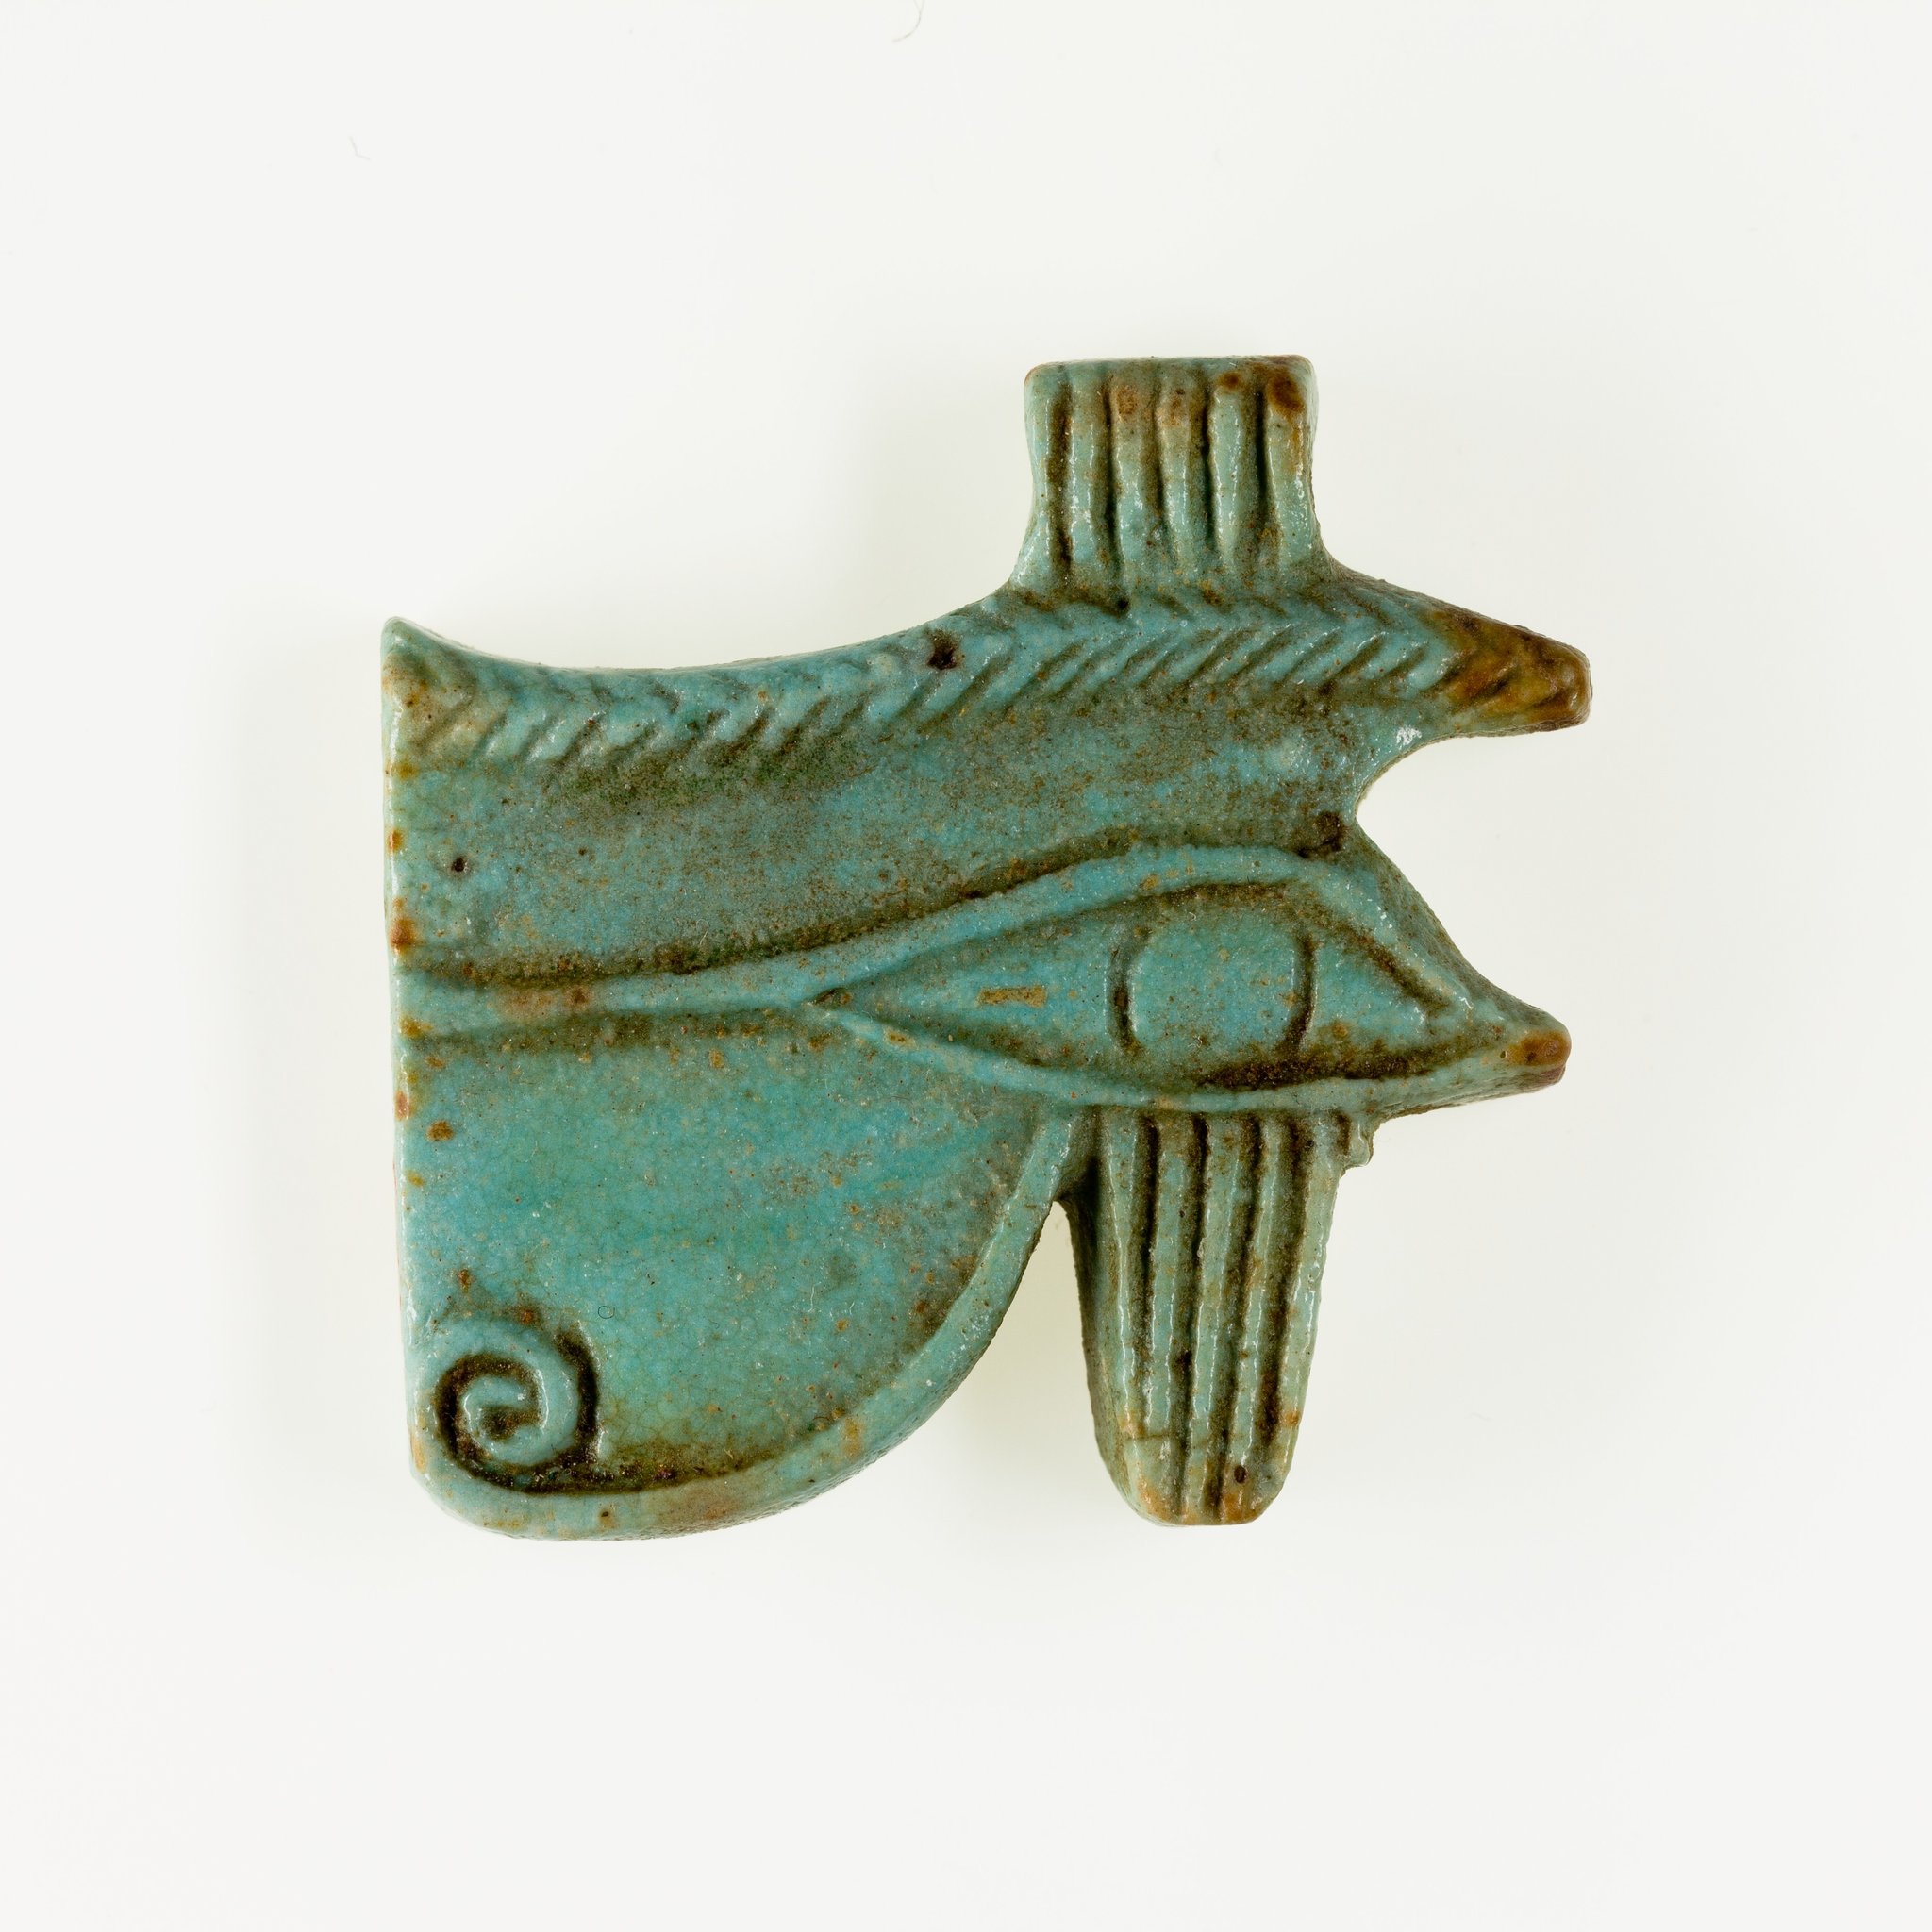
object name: amulet, wedjat eye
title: Wedjat eye amulet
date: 664-332 BCE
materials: faience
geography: egypt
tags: eyes